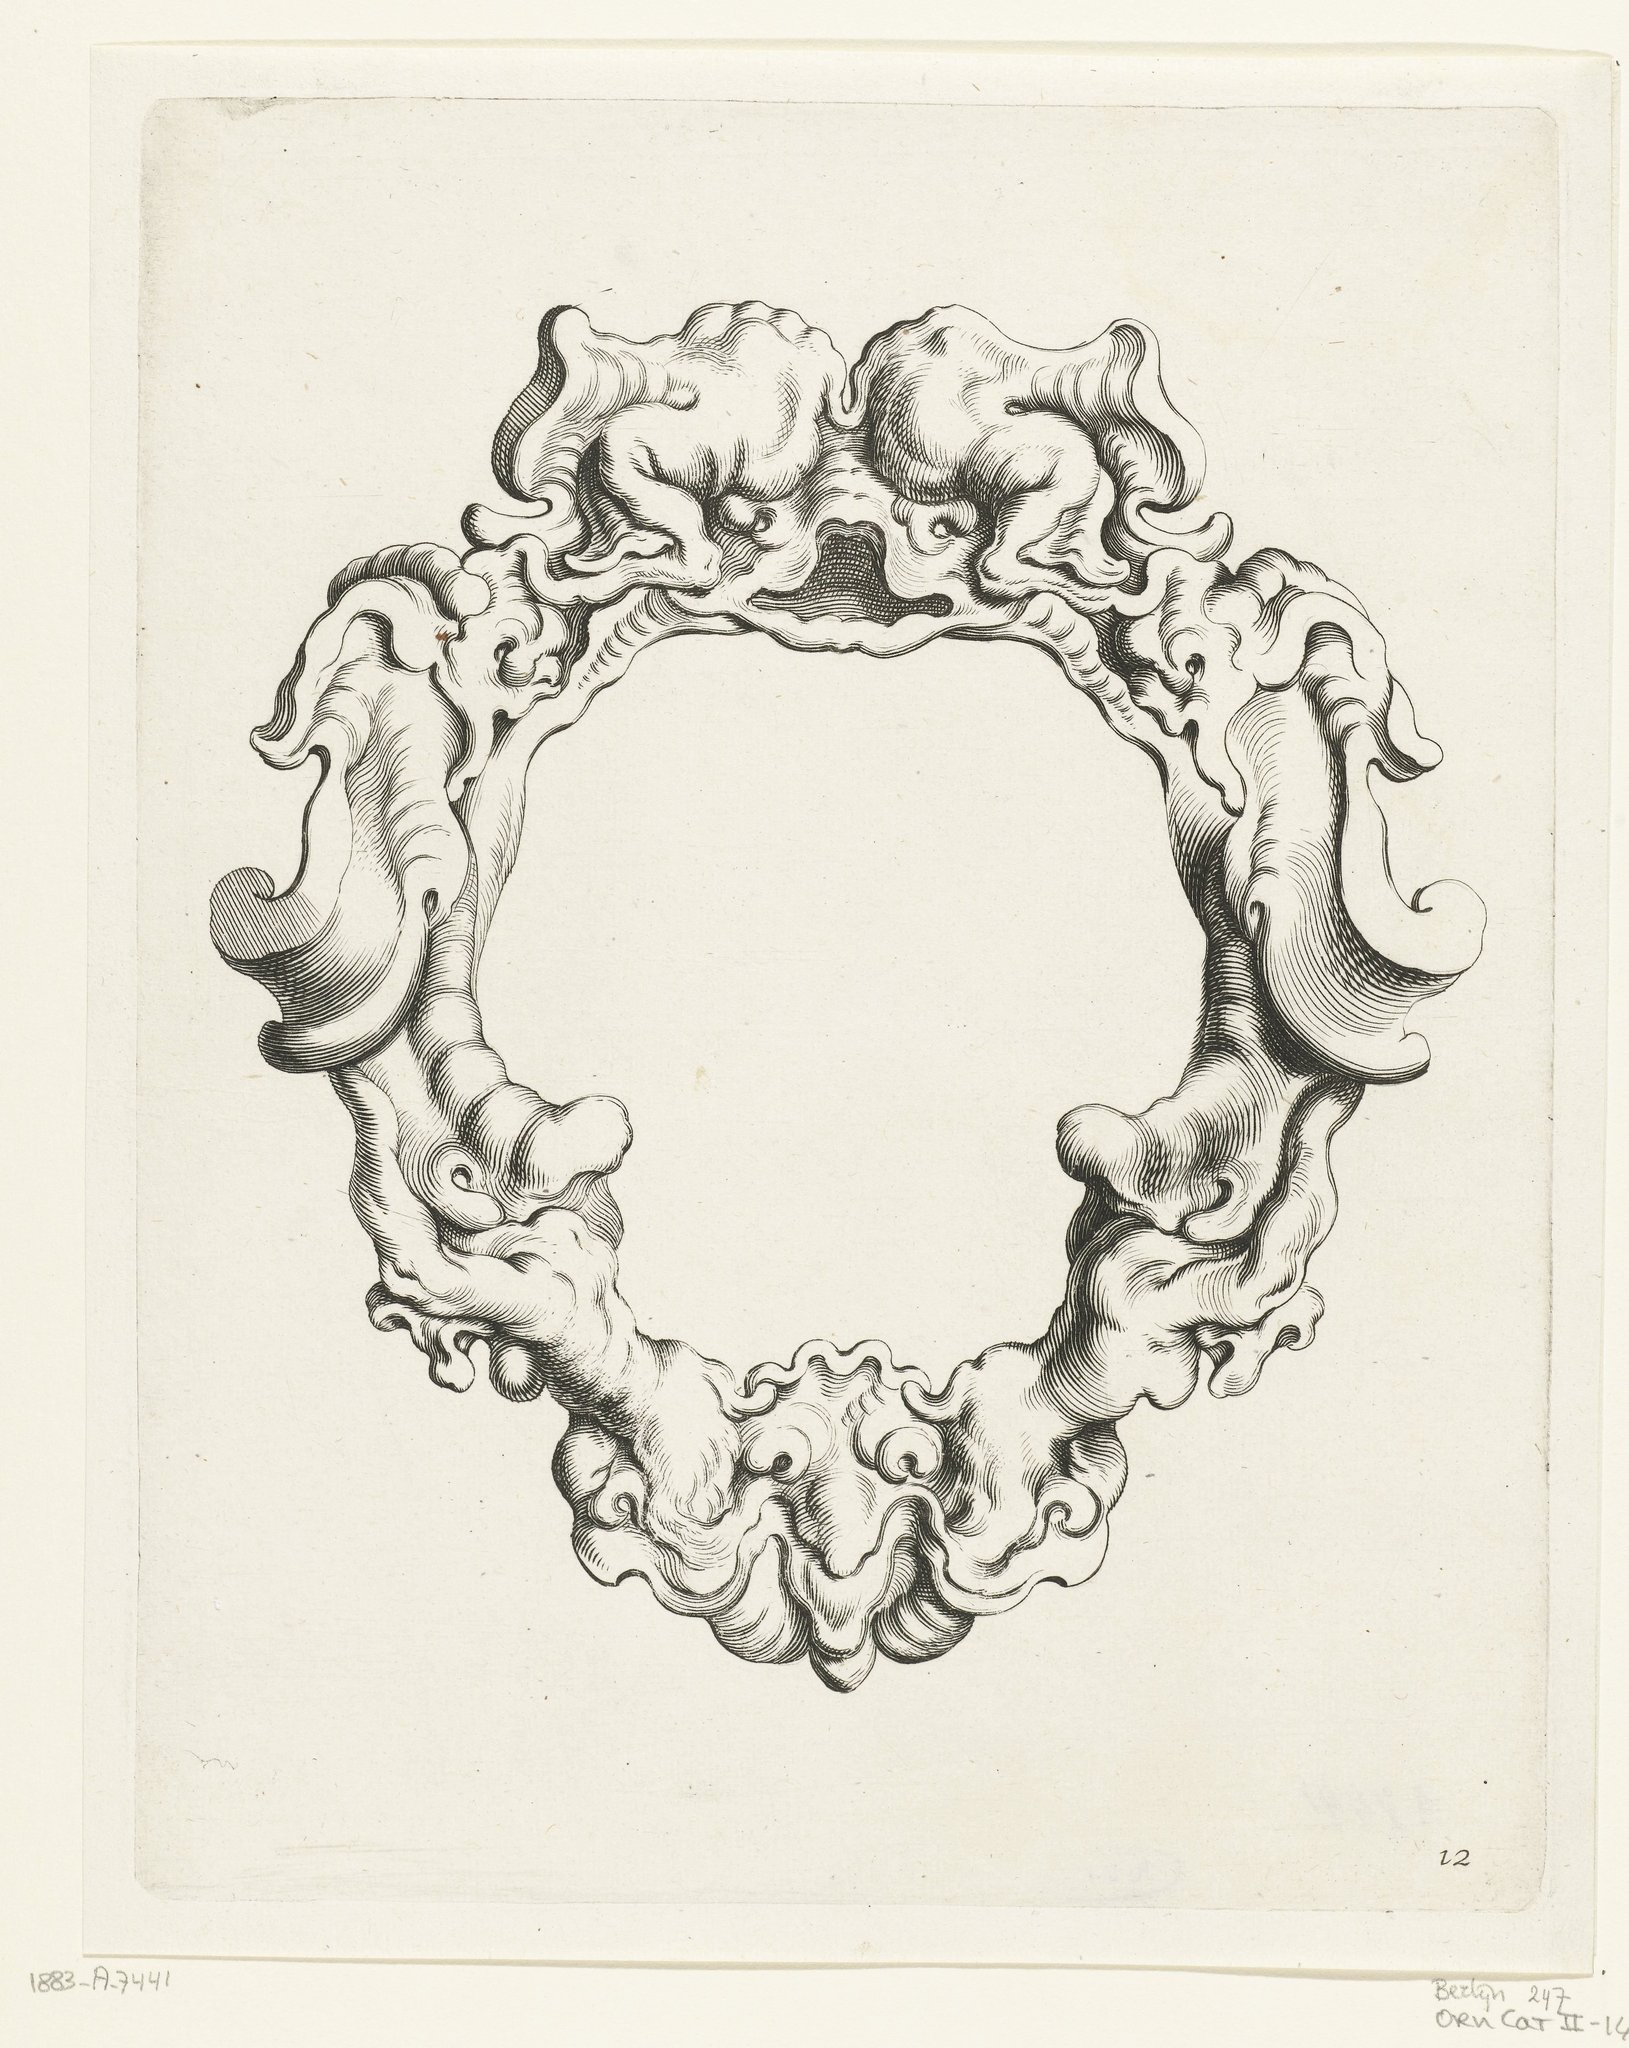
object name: print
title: Cartouche met kwabornament, bovenaan twee monsters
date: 1640-1655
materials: paper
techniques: engraving, etching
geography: amsterdam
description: De monsters zitten ineengezakt op een masker.